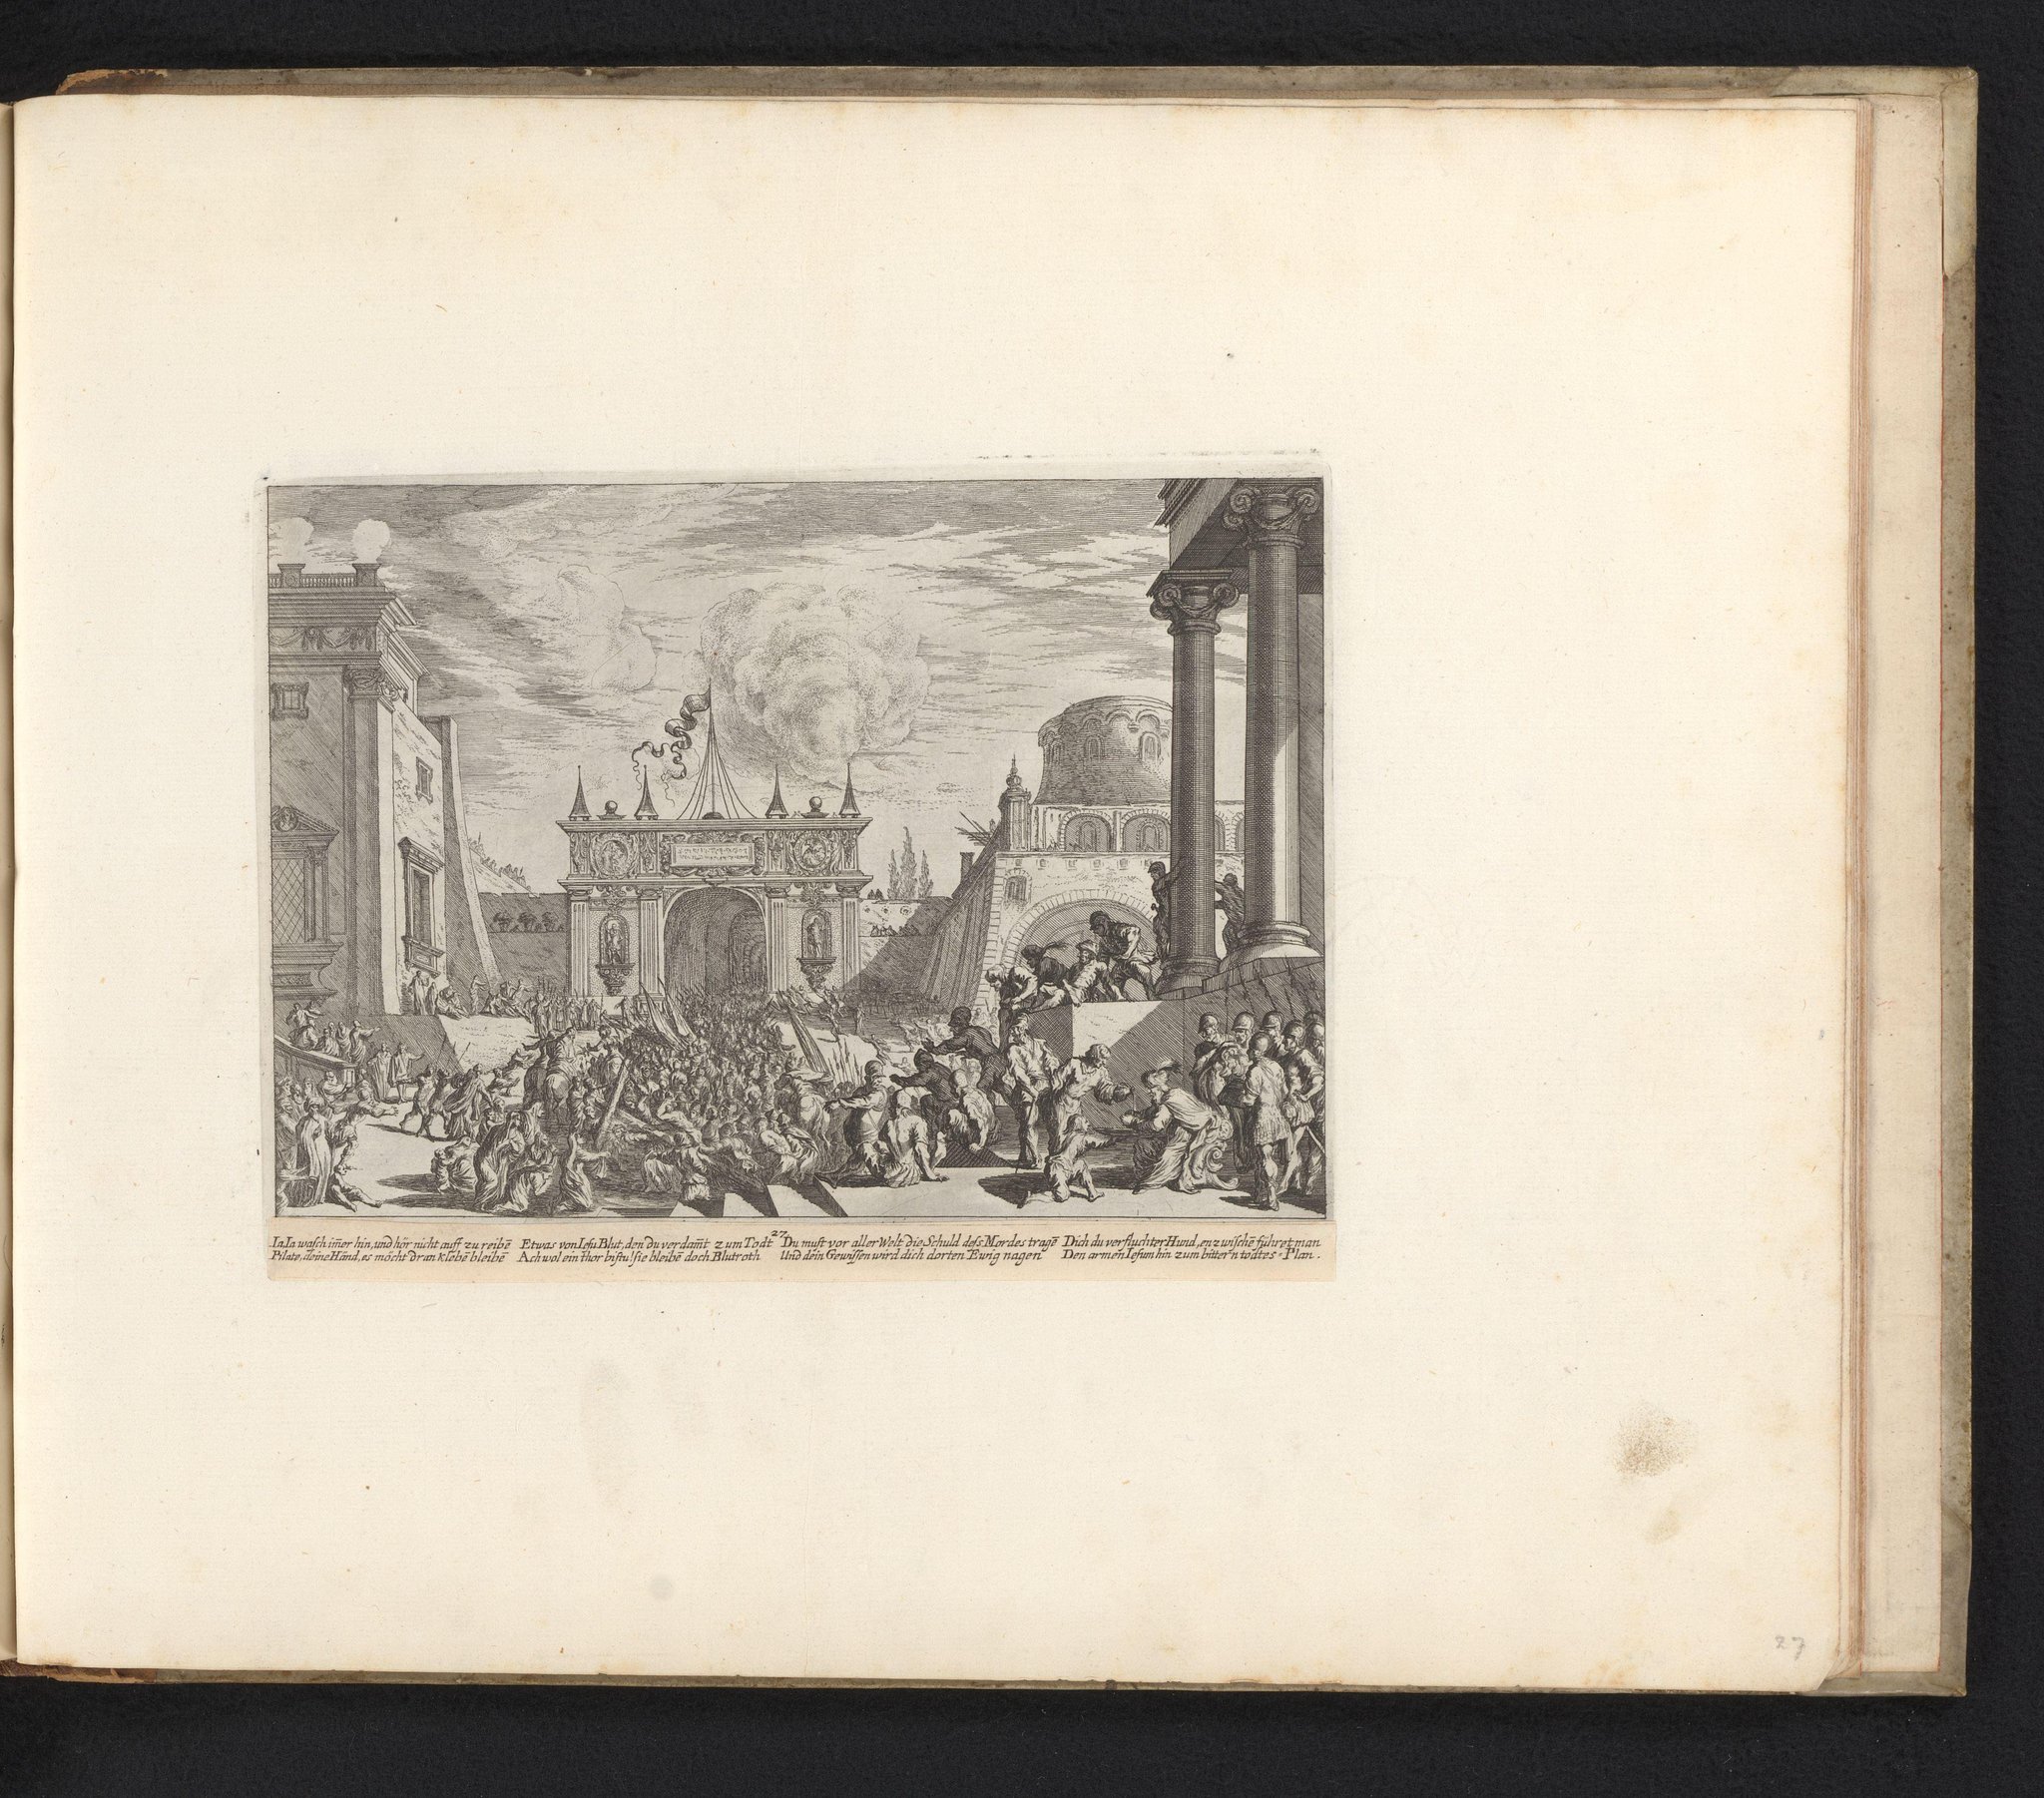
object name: print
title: Kruisdraging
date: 1670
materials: paper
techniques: etching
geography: augsburg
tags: christ meets veronica, who has a cloth to wipe christ's face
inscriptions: collector's mark: Lugt 2228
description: Christus draagt het kruis en voor hem knielt Veronica om met een doek het zweet van zijn gezicht te wissen. Tekst in het Duits in de ondermarge. Prent maakt deel uit van een album.